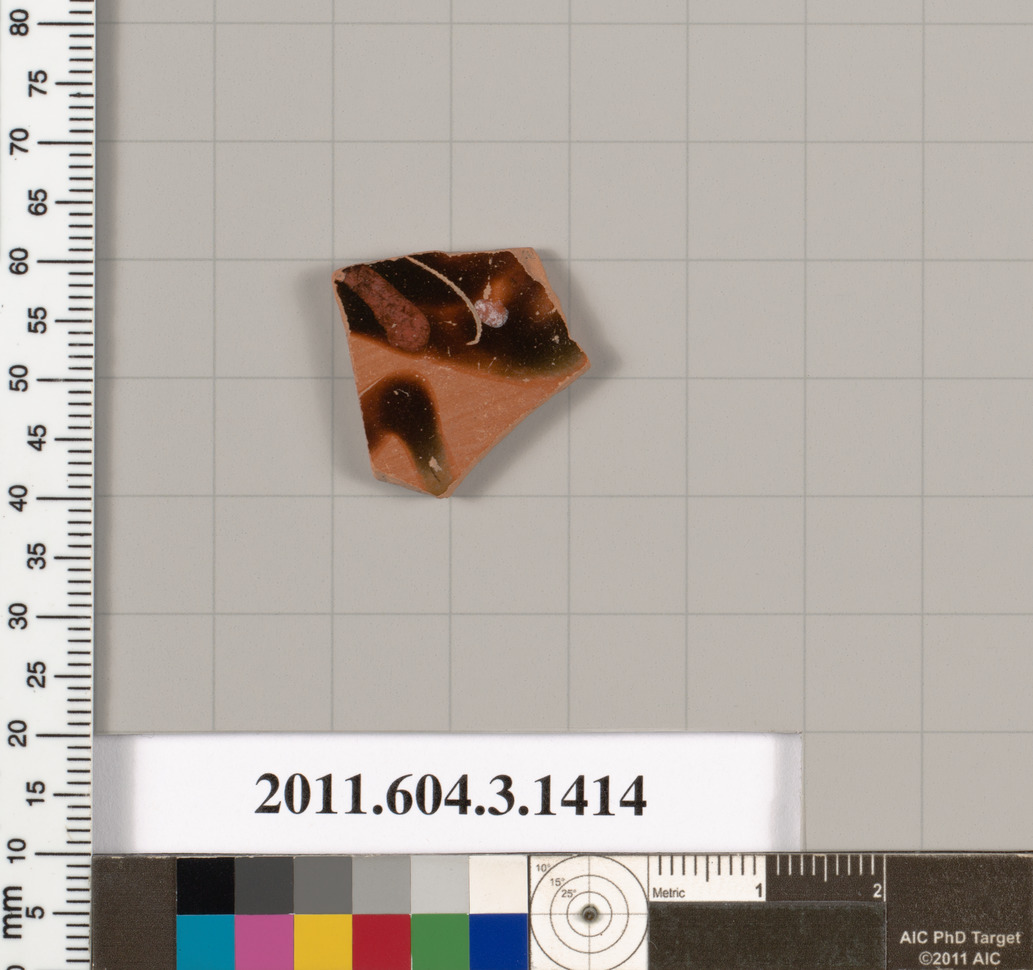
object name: skyphos fragment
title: Terracotta fragment of a skyphos (deep drinking cup)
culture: greek, attic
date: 534-468 BCE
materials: terracotta